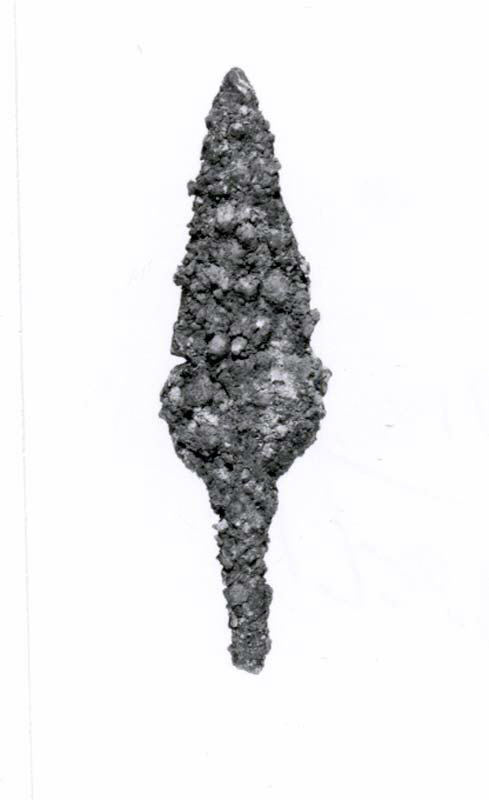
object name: arrowhead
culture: iranian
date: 900-801 BCE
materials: iron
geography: iran